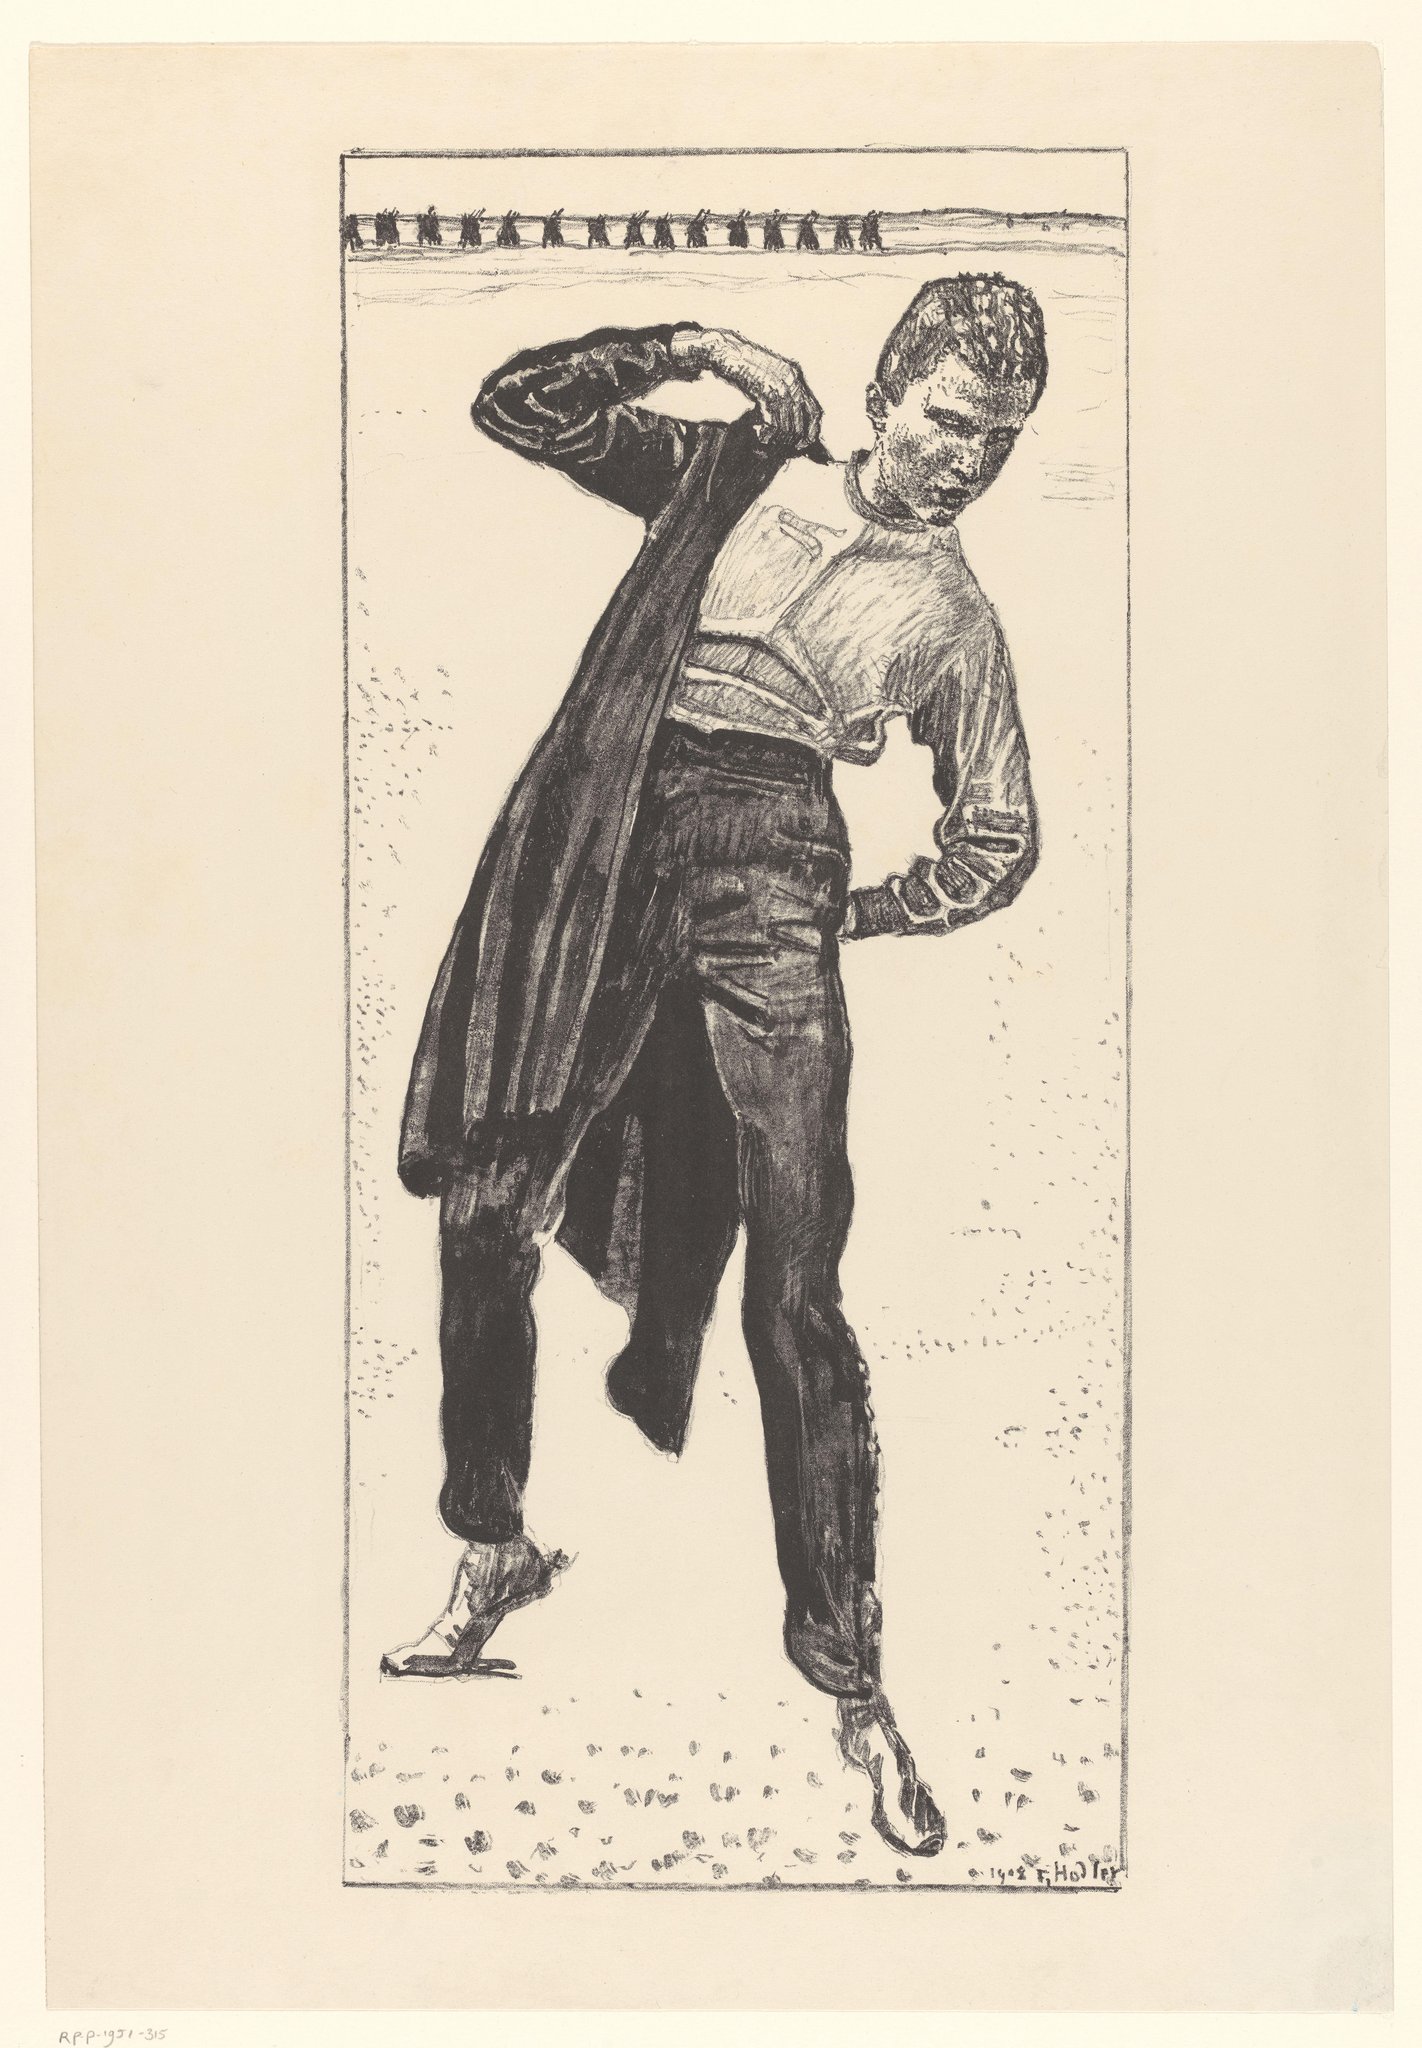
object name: print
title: Jongen die zijn jas aantrekt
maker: ferdinand hodler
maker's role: draughtsman, print maker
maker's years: 1853-1918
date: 1908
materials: paper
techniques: lithograph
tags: youth, adolescent, coat, cape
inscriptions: collector's mark: Lugt 2228